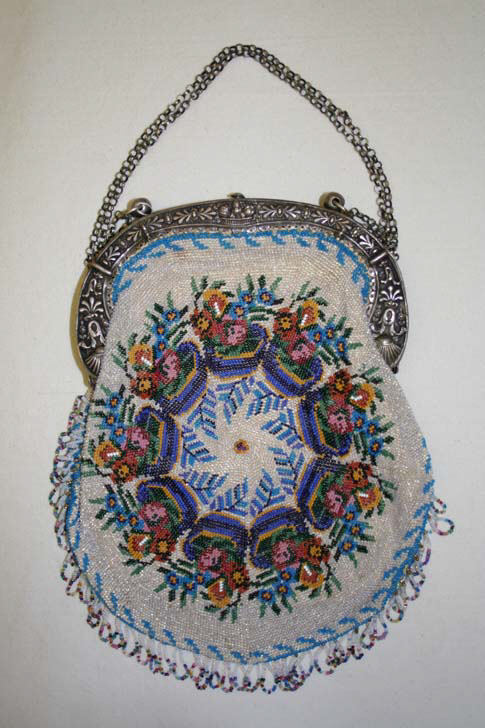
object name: bag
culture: french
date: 1825-1835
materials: silver